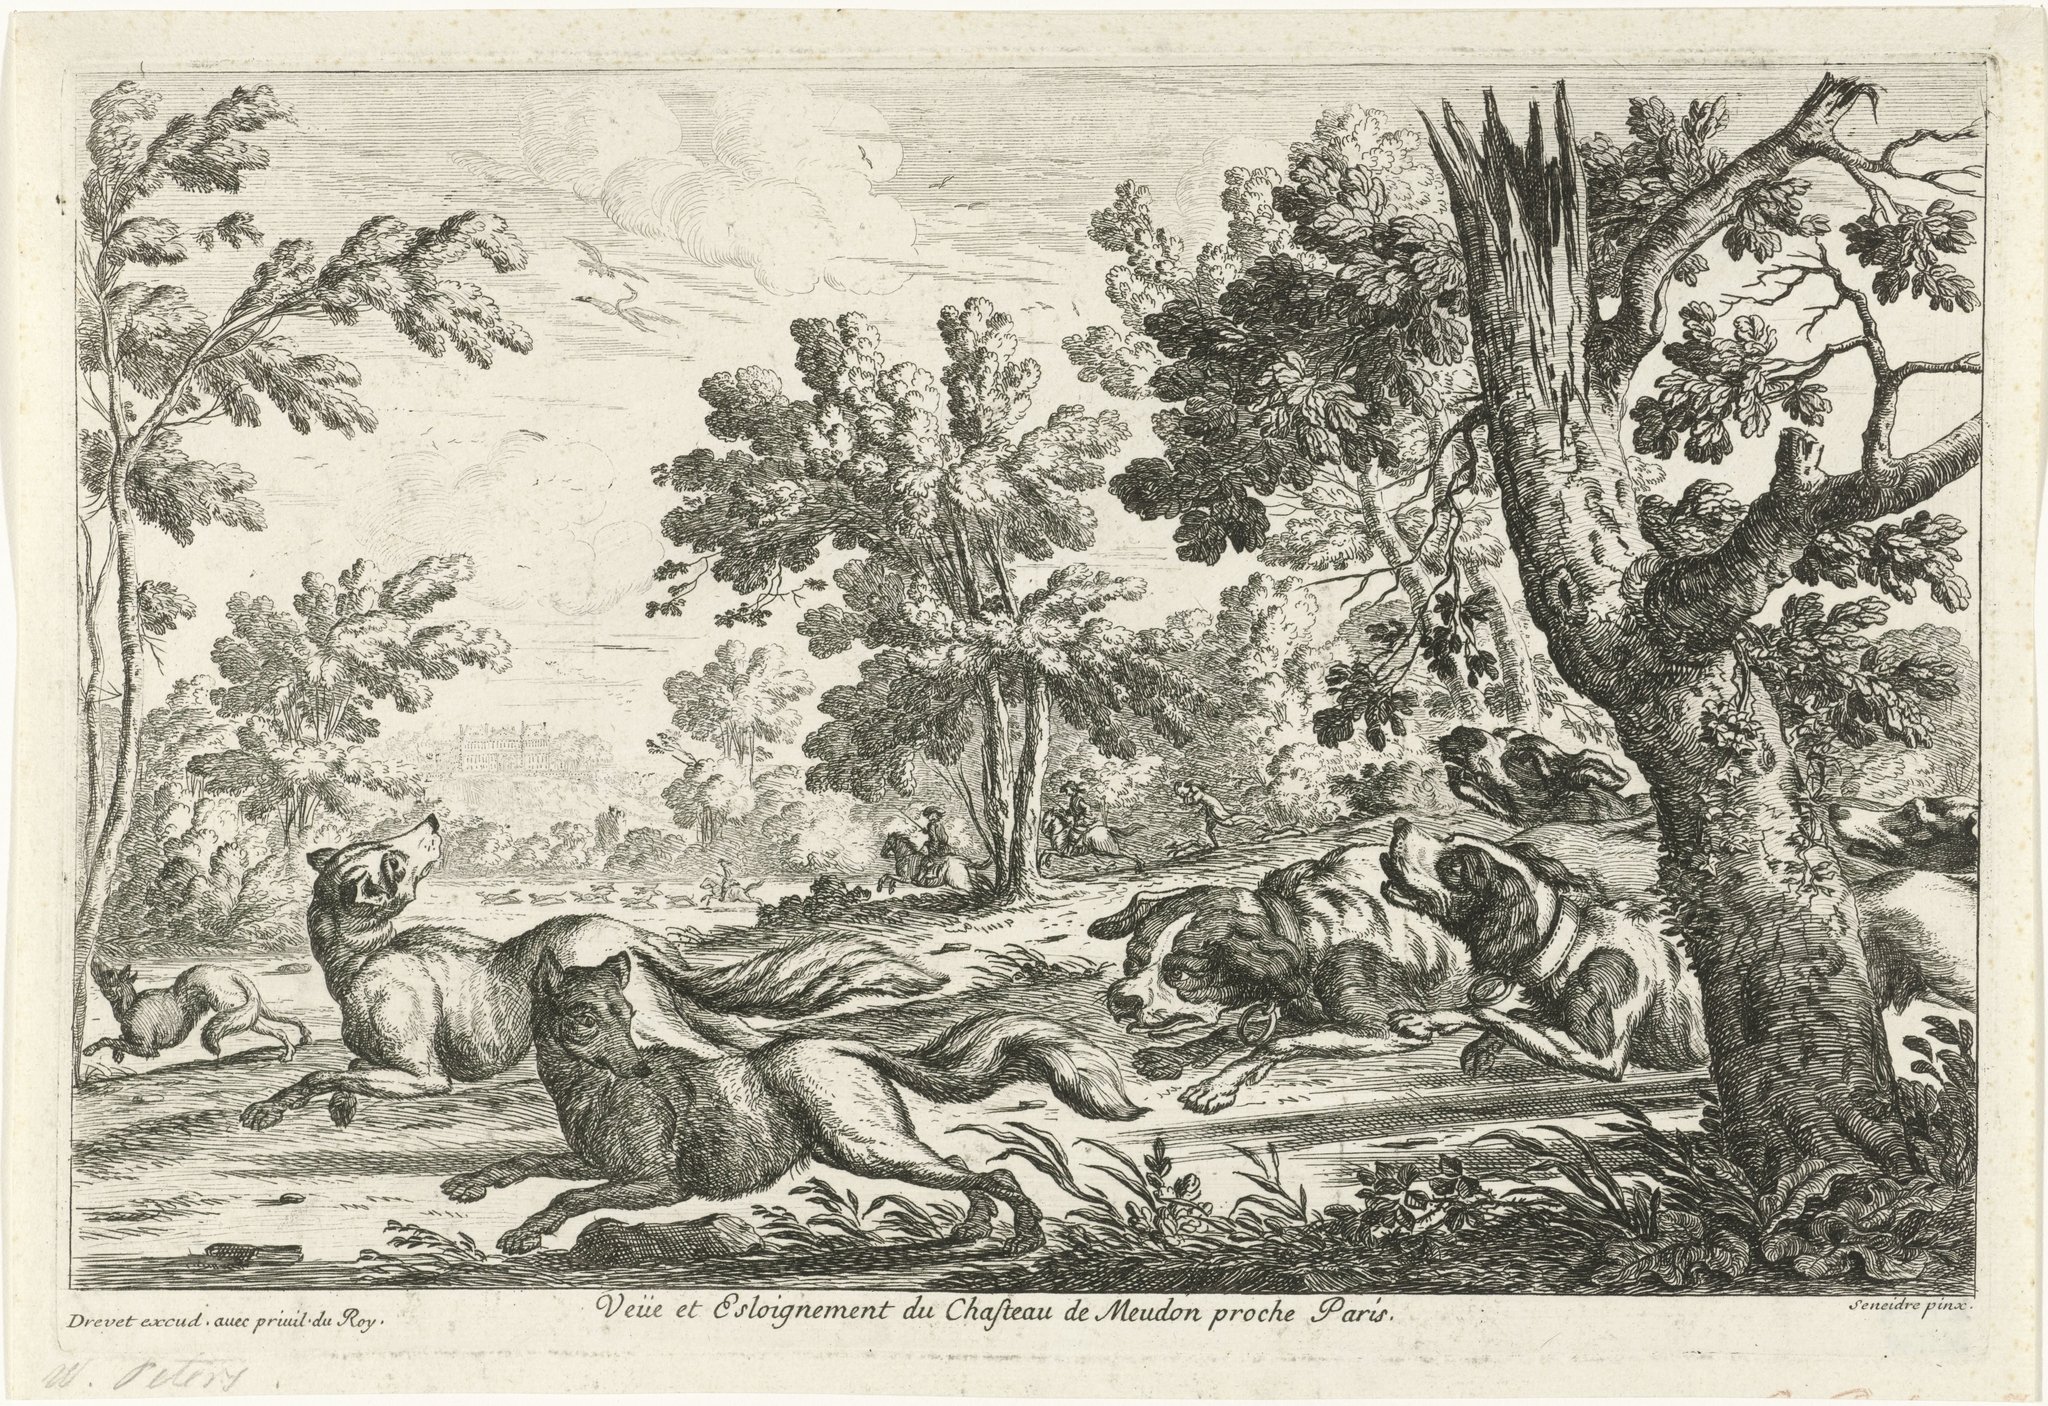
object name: print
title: Fox Hunt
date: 1622-1653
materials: paper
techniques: etching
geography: antwerp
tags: fox hunting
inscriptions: collector's mark: Lugt 2165, collector's mark: Lugt 2228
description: Landschap met een vossenjacht. Links op de achtergrond een gezicht op Château de Meudon, nabij Parijs. In de marge een onderschrift in het Frans.